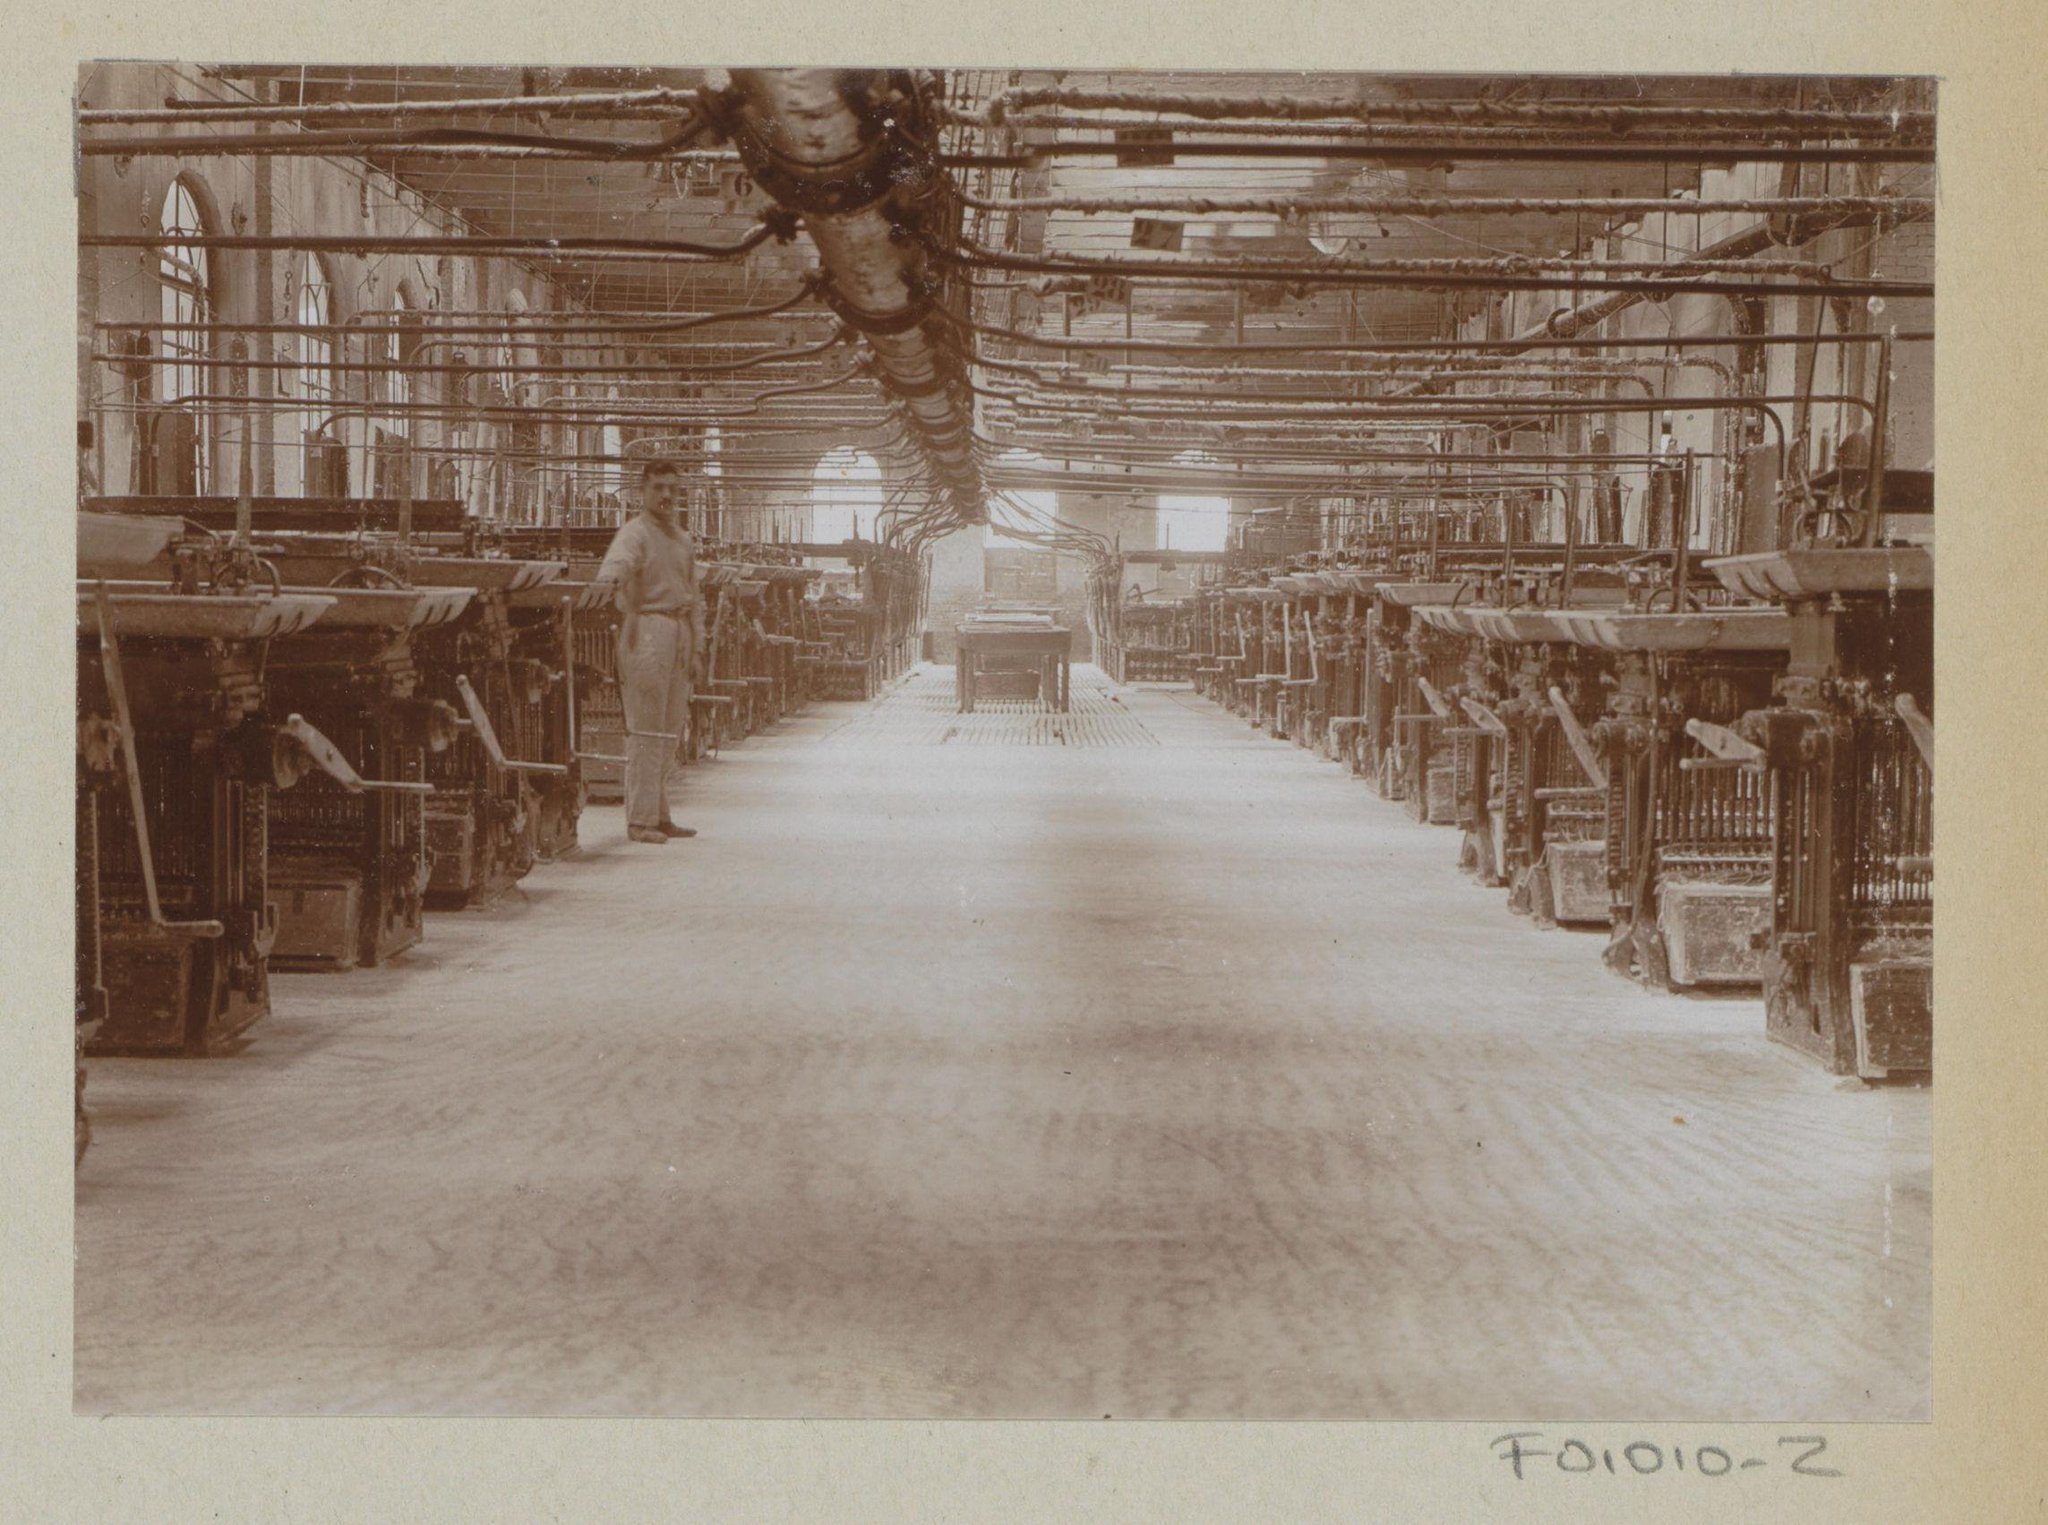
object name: photograph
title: Interieur van een fabriekshal met machines en een werknemer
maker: Anonymous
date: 1900-1910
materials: photographic support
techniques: collodion silver print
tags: factory-interior, machine shop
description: Onderdeel van Familiealbum met onder meer foto's van Wijnhandel Kraaij & Co. Bordeaux-Amsterdam.